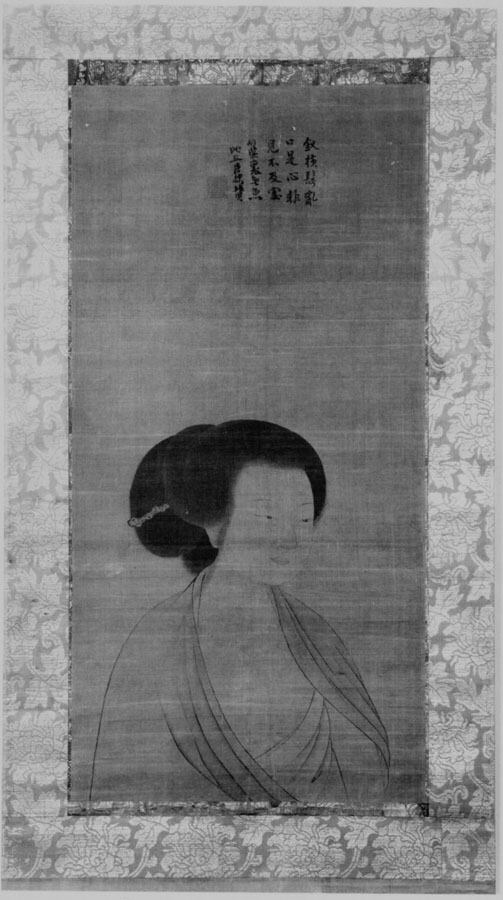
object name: hanging scroll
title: Portrait of a Lady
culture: chinese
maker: unidentified artist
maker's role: artist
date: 1301-1400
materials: ink, silk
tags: portraits,women